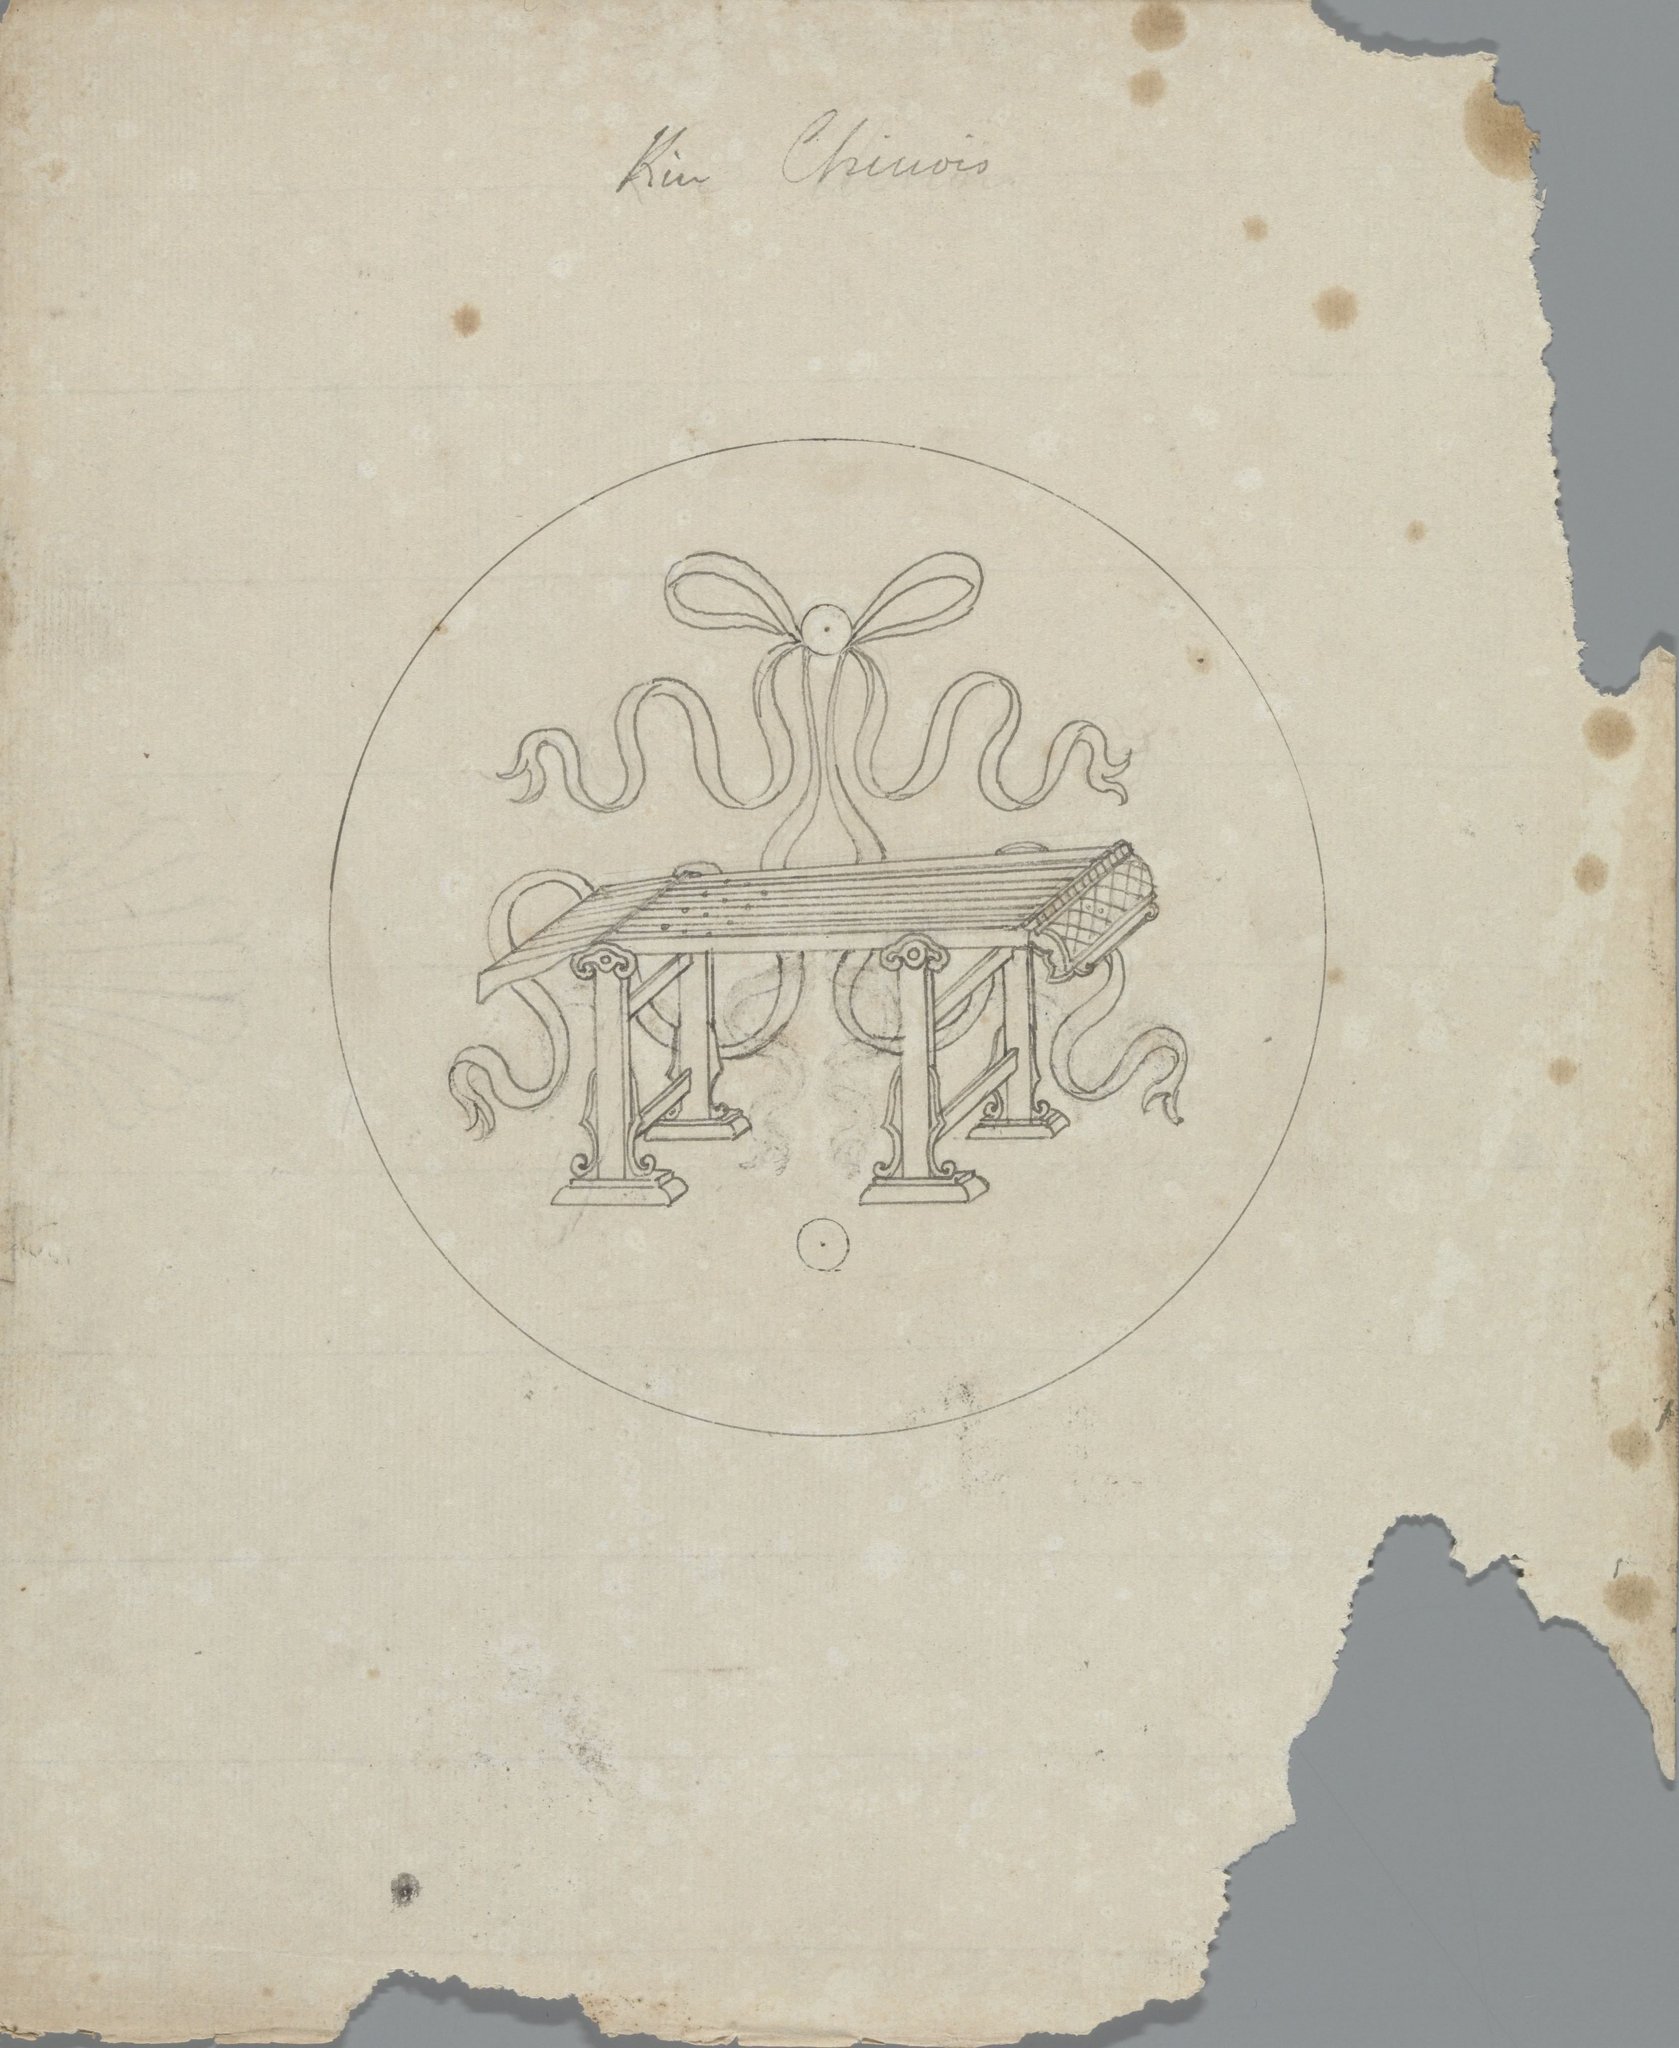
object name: design drawing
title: Kin Chinois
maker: pierre félix van doren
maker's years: 1797-1856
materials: graphite, ink, paper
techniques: pen in black ink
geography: brussels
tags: musical instruments; group of musical instruments, trophy, i.e.: decorative arrangement of symbolic or typical objects ~ ornament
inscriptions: inscription: ‘Kin Chinois’, watermark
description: Een van 103 ontwerpen voor marqueterie van aan linten opgehangen muziekinstrumenten in ronde medaillons, bestemd voor de set stoelen gemaakt door Van Doren voor de grote zaal van het Paleis van de Prins van Oranje in Brussel in 1828.